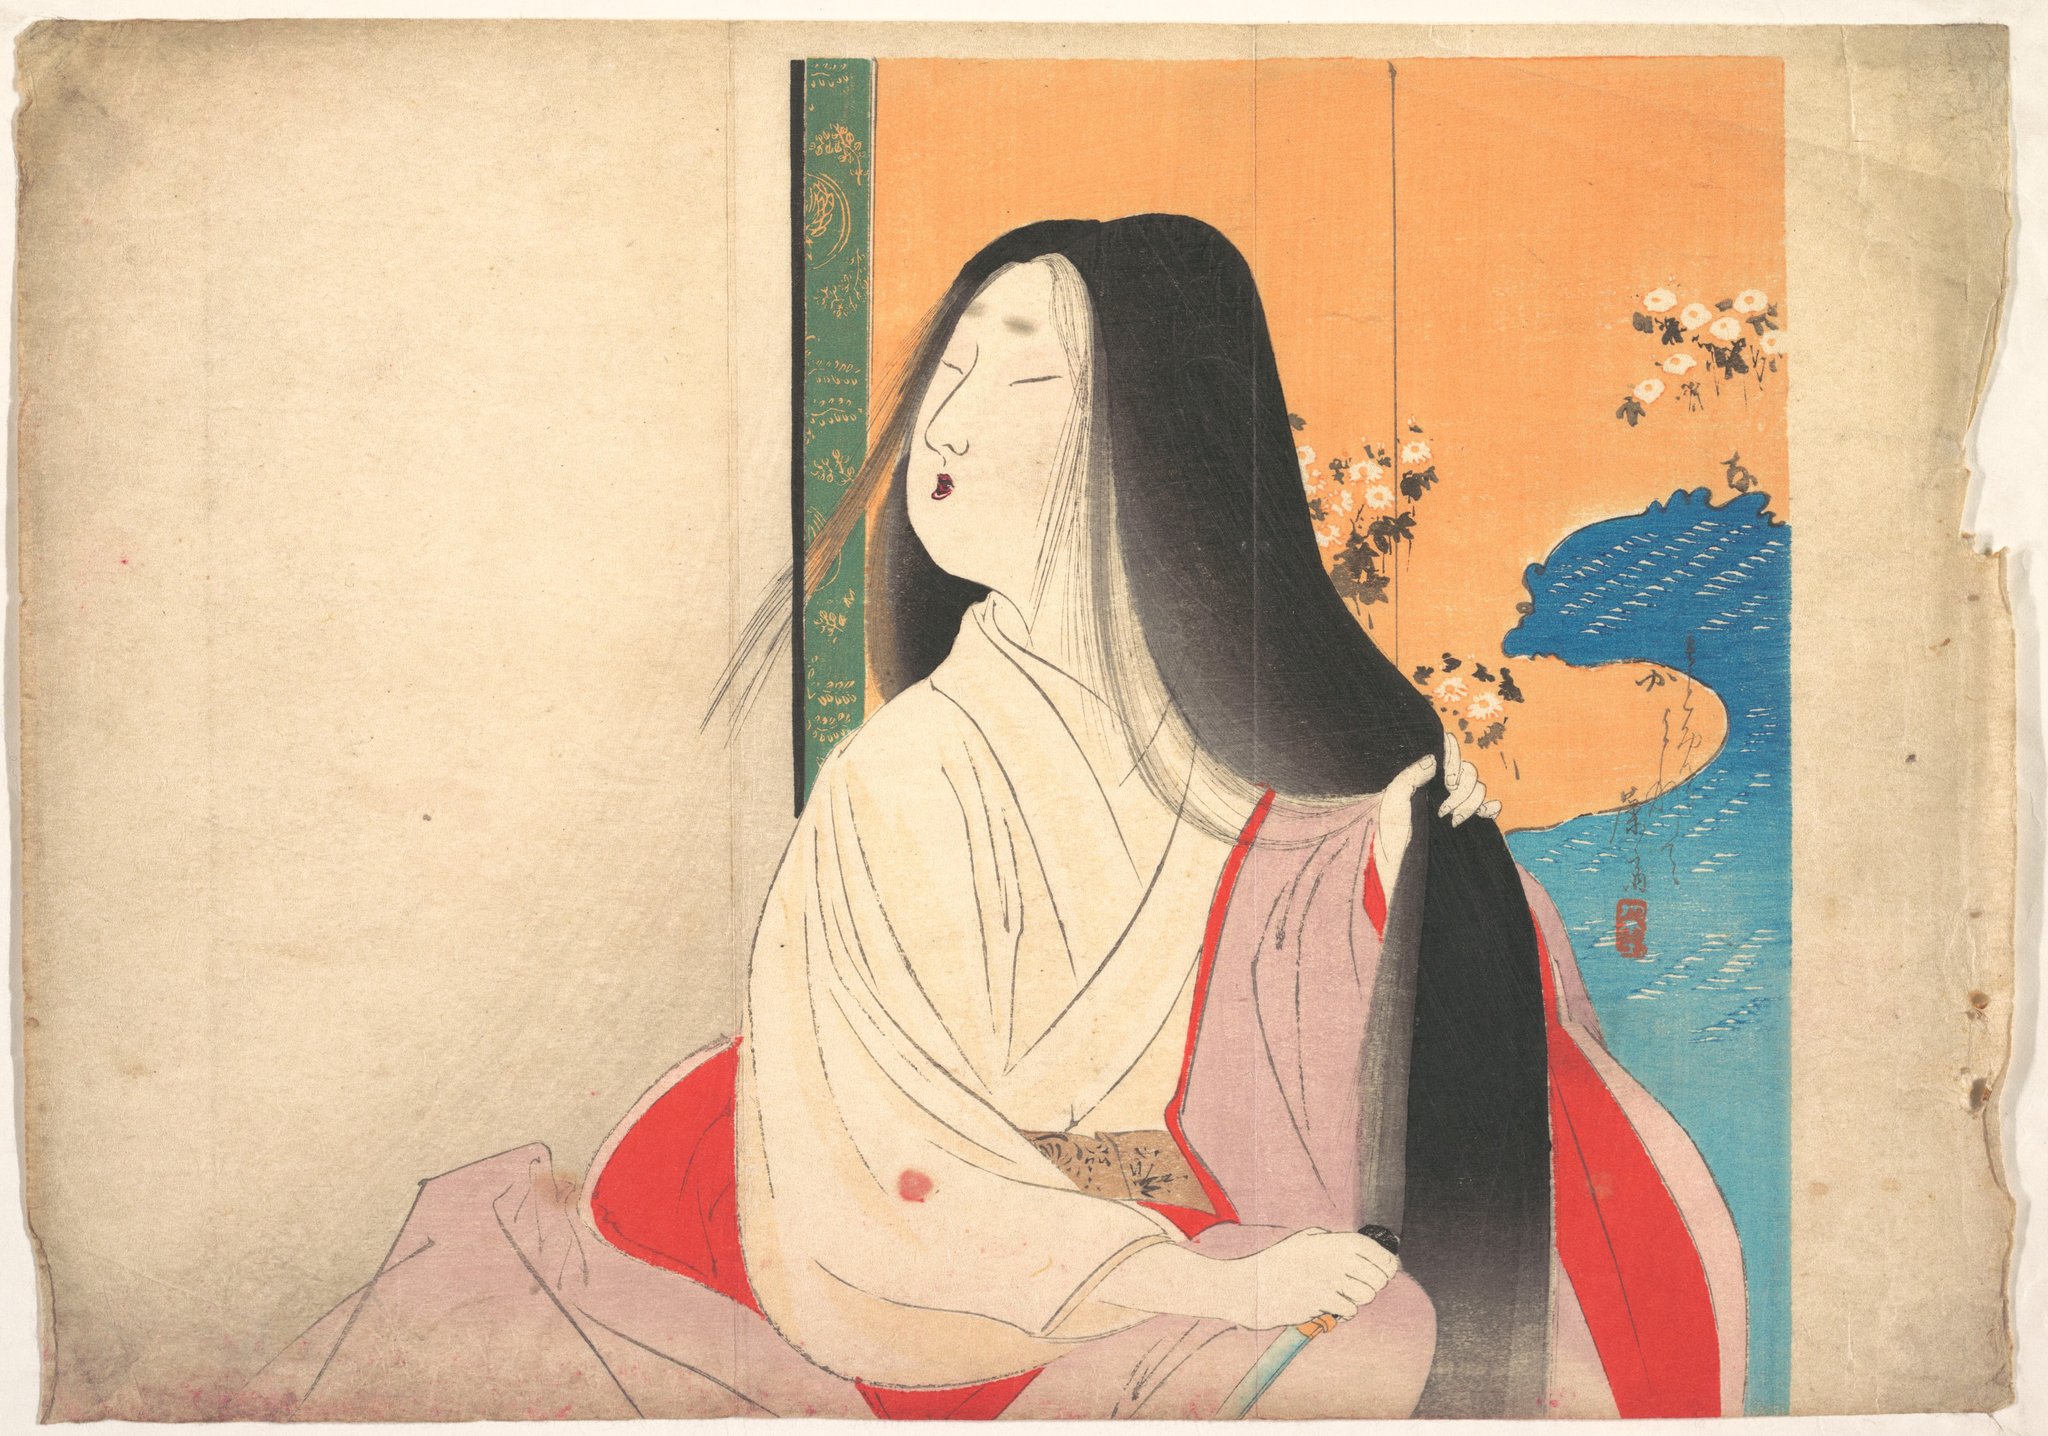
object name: print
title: Lady Kesa from kuchie (frontispiece) of a novel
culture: japanese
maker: tomioka eisen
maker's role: artist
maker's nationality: japanese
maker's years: 1864-1905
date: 1906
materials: ink, paper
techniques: woodblock print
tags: women